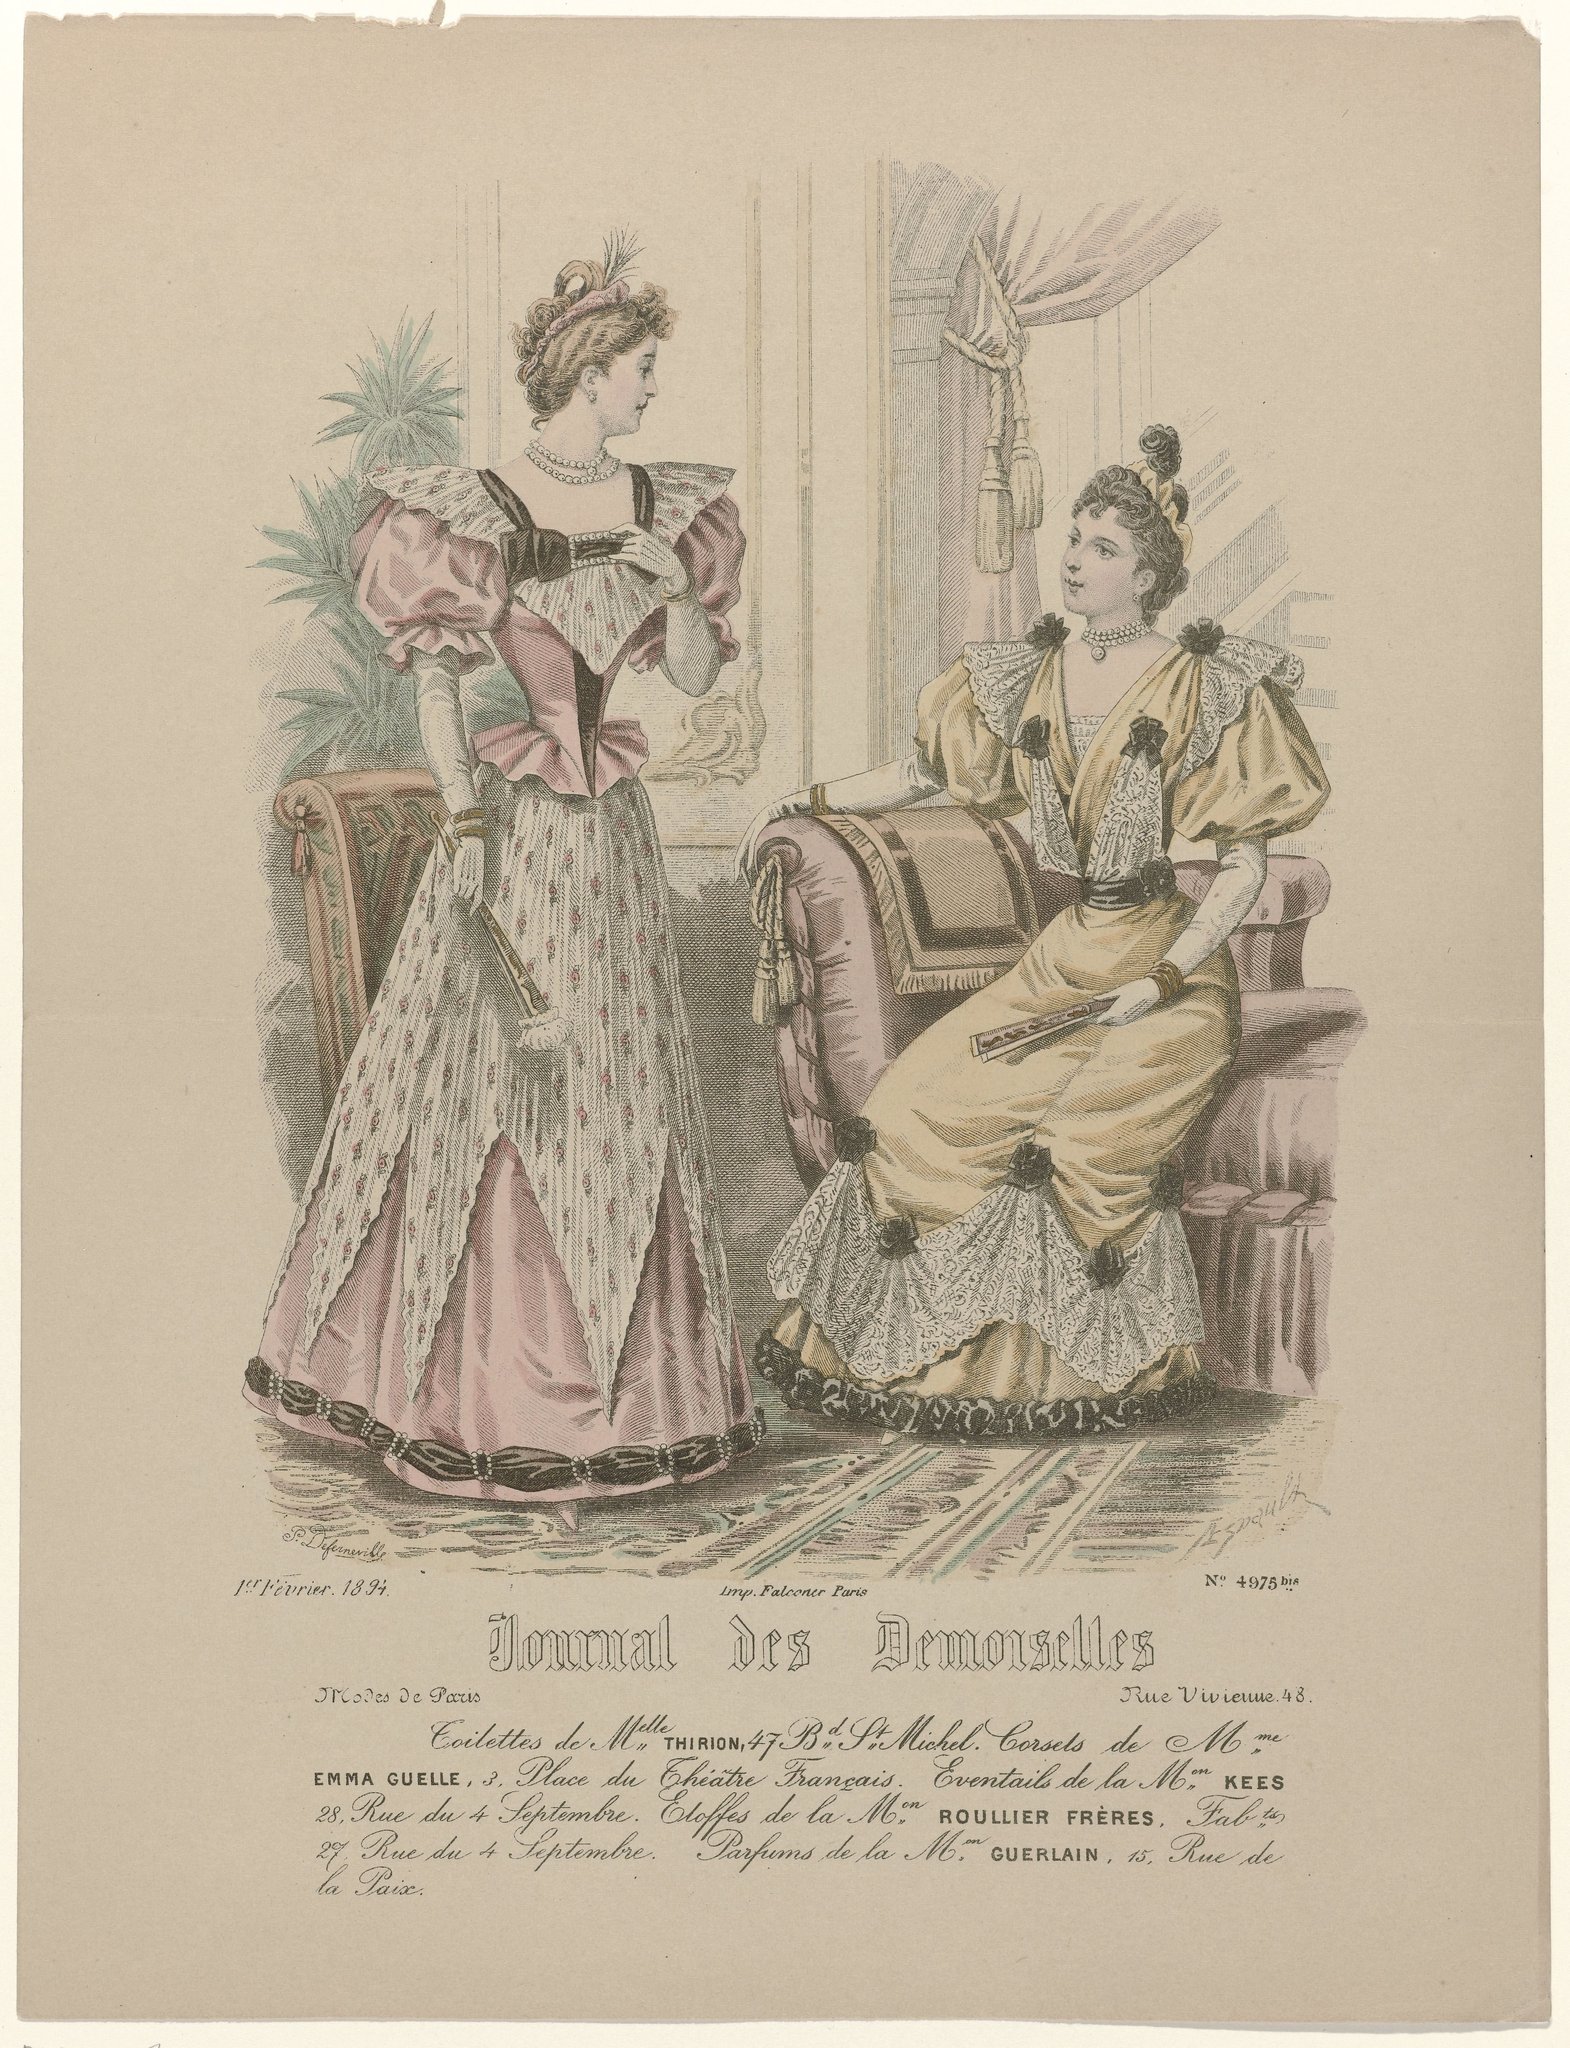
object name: fashion print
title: Journal des Demoiselles, 1 fevrier 1894, No. 4975 bis : Toilettes de Melle Thirion (...)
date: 1894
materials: paper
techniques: engraving, hand coloring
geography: paris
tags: ear-rings (+ women's clothes), fashion plates, gloves, mittens, etc. (+ women's clothes), dress, gown (+ women's clothes), fan (+ women's clothes), necklace (+ women's clothes)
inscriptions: caption: ‘Toilettes de M.elle Thirion, 47 B.d S.t Michel. Corsets de M.me Emma Guelle, 3, Place du Théâtre Français. evenatils de la M.on Kees 28, Rue du 4 Septembre. Etoffes de la M.on Roullier Frères. Fab.ts 27. Rue du 4 septembre. Parfums de la M.on Guerlain, 15, Rue de la Paix.’, title: ‘Journal des Demoiselles’, address: ‘Modes de Paris / Rue Vivienne. 48’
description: Twee vrouwen in een interieur. Volgens het onderschrift: 'toilettes' van Thirion. Hieronder enkele regels reclametekst voor verschillende producten. Prent uit het modetijdschrift Journal des Demoiselles (1833 -1922).